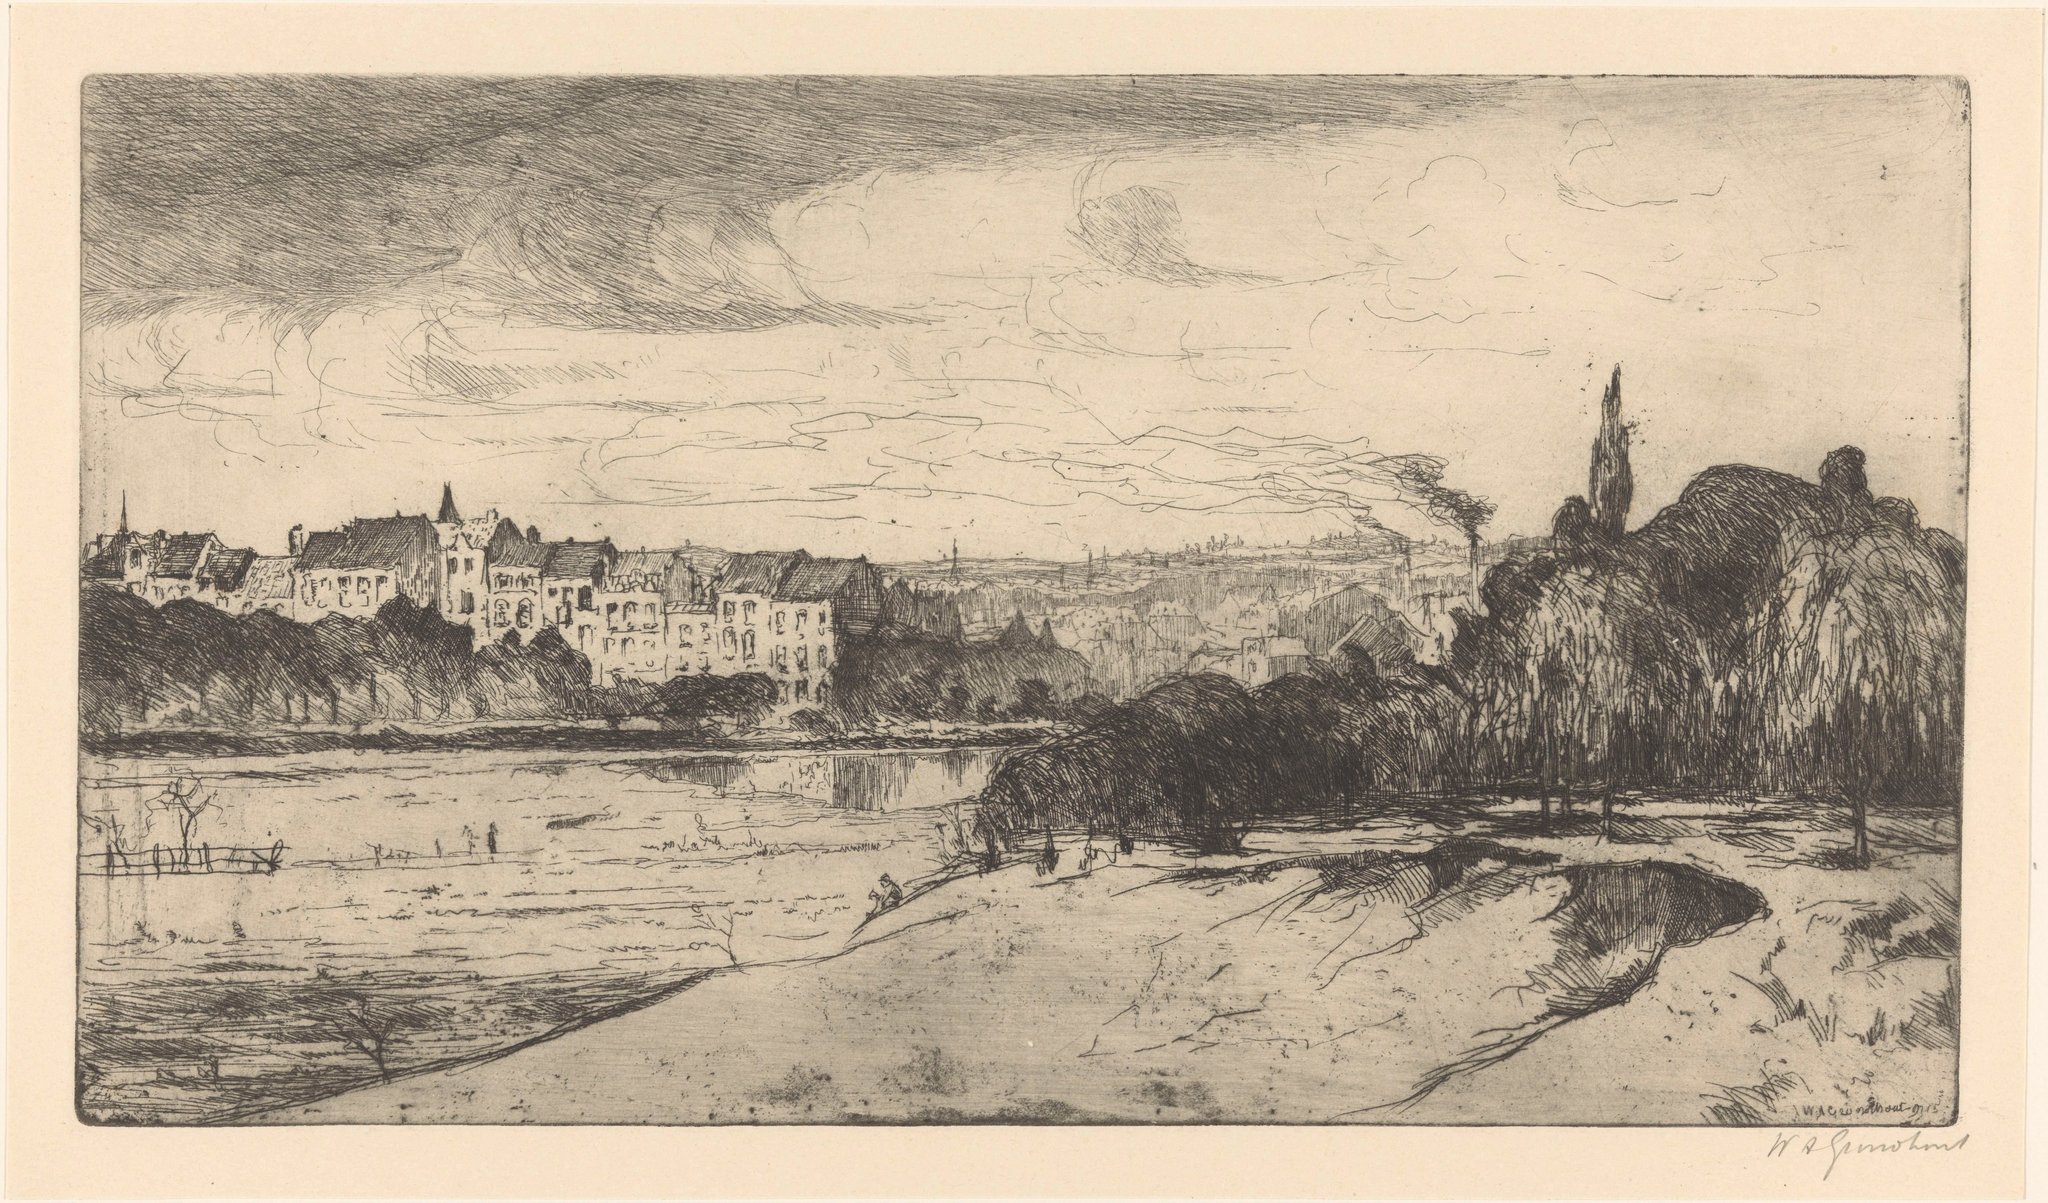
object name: print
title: Stad aan een rivier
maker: willem adrianus grondhout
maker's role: draughtsman, painter, print maker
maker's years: 1878-1934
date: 1888-1931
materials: paper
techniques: etching, intaglio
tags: city-view, and landscape with man-made constructions, river